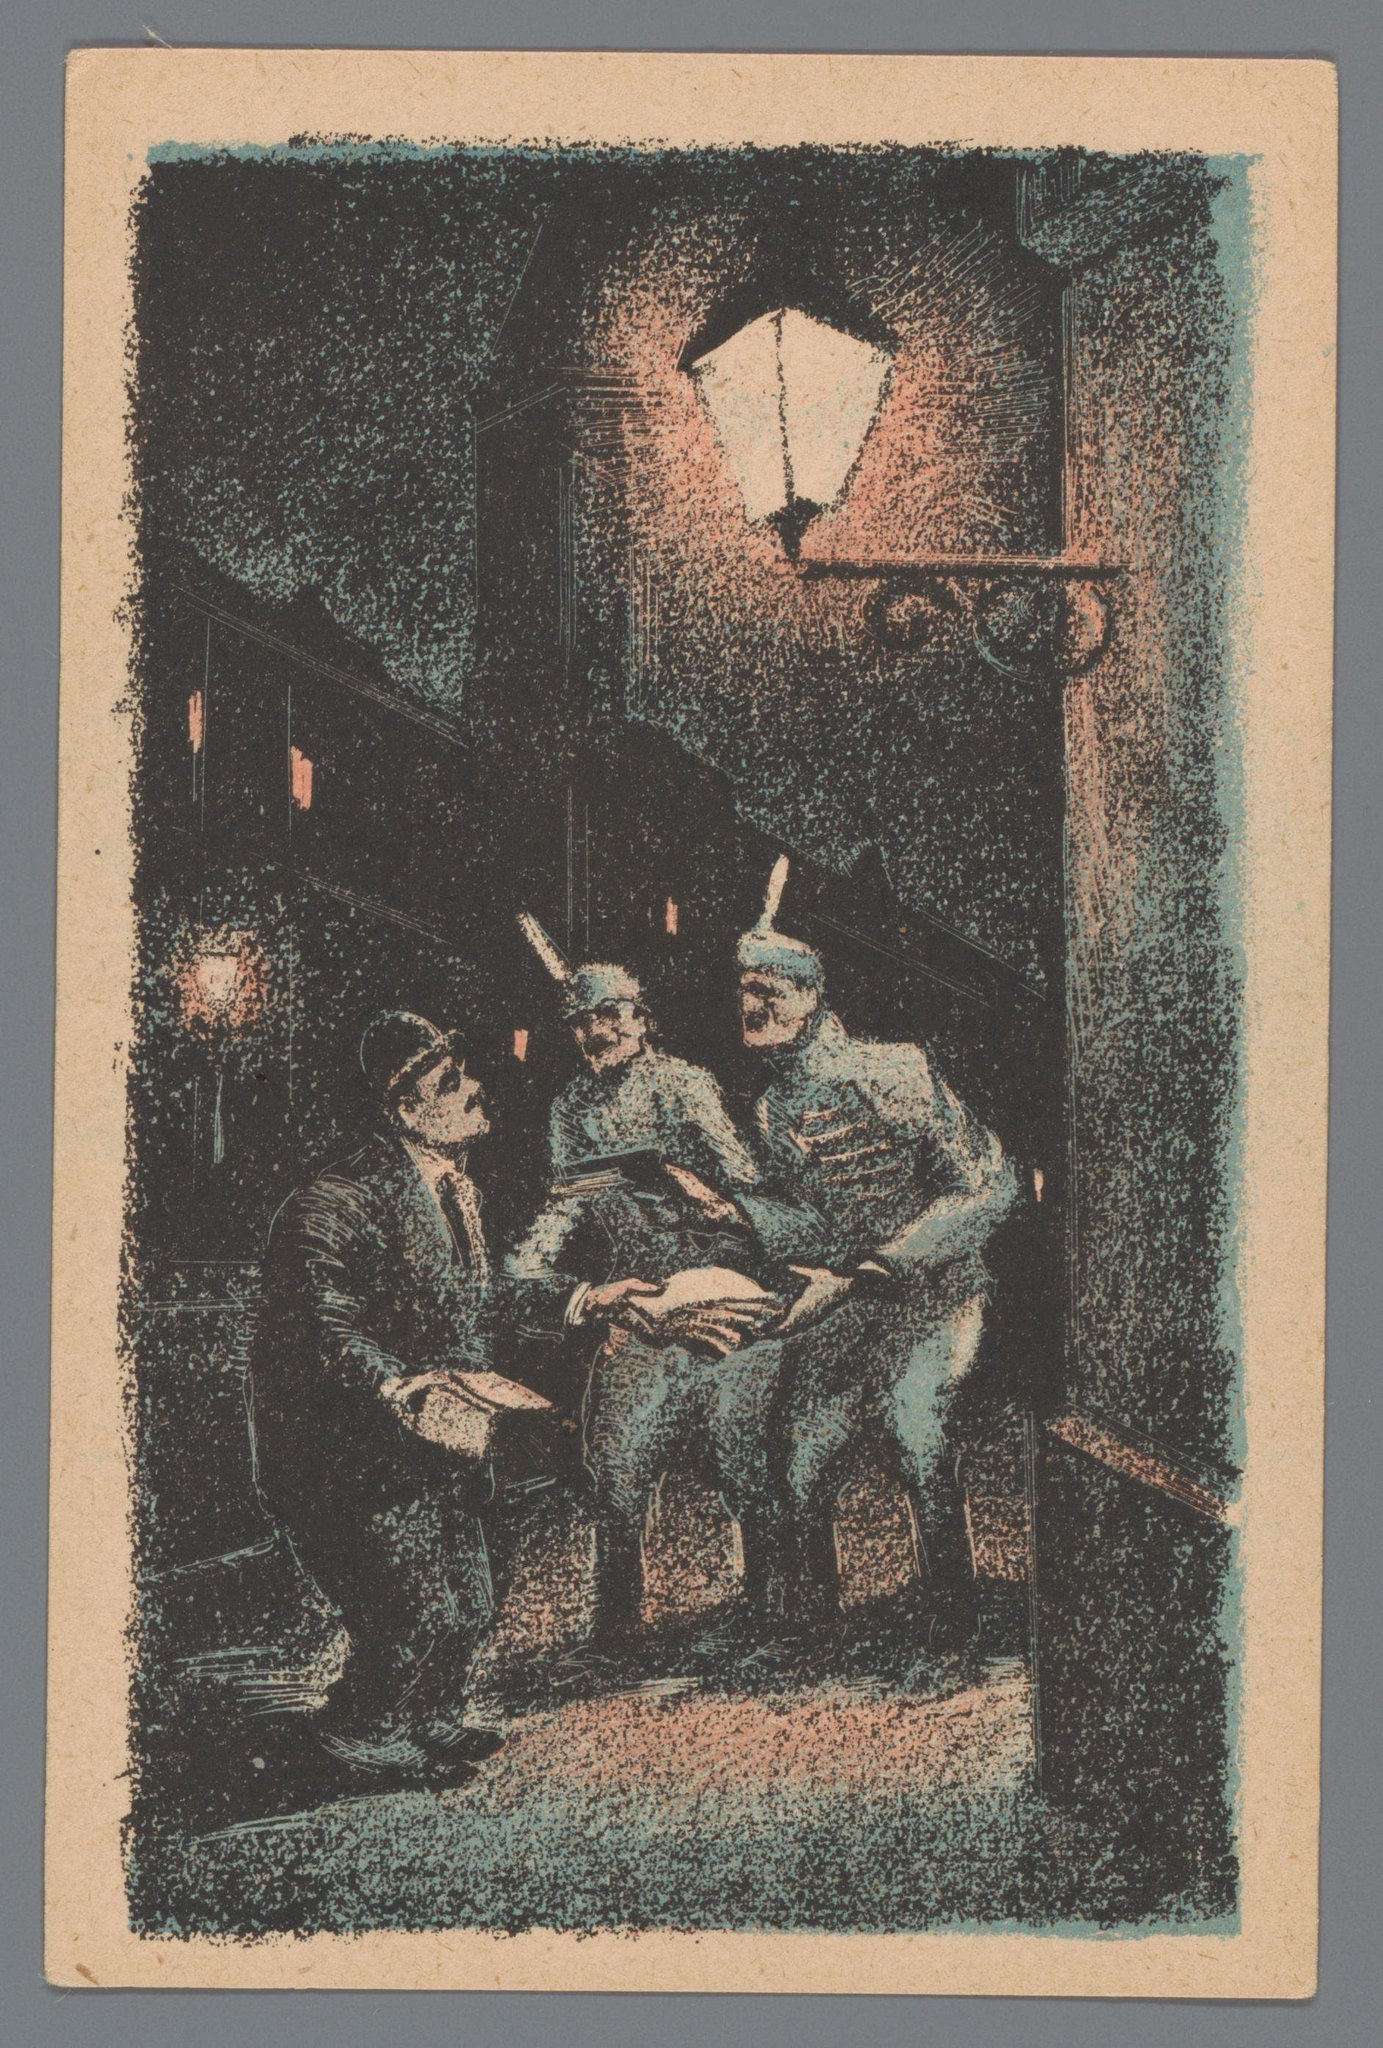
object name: print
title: Man overhandigt geld aan twee soldaten onder een straatlantaarn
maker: mihály biró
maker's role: draughtsman, painter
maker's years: 1886-1948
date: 1920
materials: paper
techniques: letterpress printing, lithograph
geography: vienna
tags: reign of terror, bribery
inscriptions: : ‘Nachdruk verboten.’, : ‘Original Lithographie von Michael Biró.’, collector's mark: Lugt 2228, : ‘Verlag der Arbeiter-Buchhandlung, Wien, VIII. Alserstrasse 69.’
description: Voorstelling van de barre omstandigheden in Hongarije ten tijde van witte terreur onder het schrikbewind van Miklós Horthy. Titel op object in het Hongaars, Frans, Duits, Engels en Russisch en tekst in het Duits op verso.